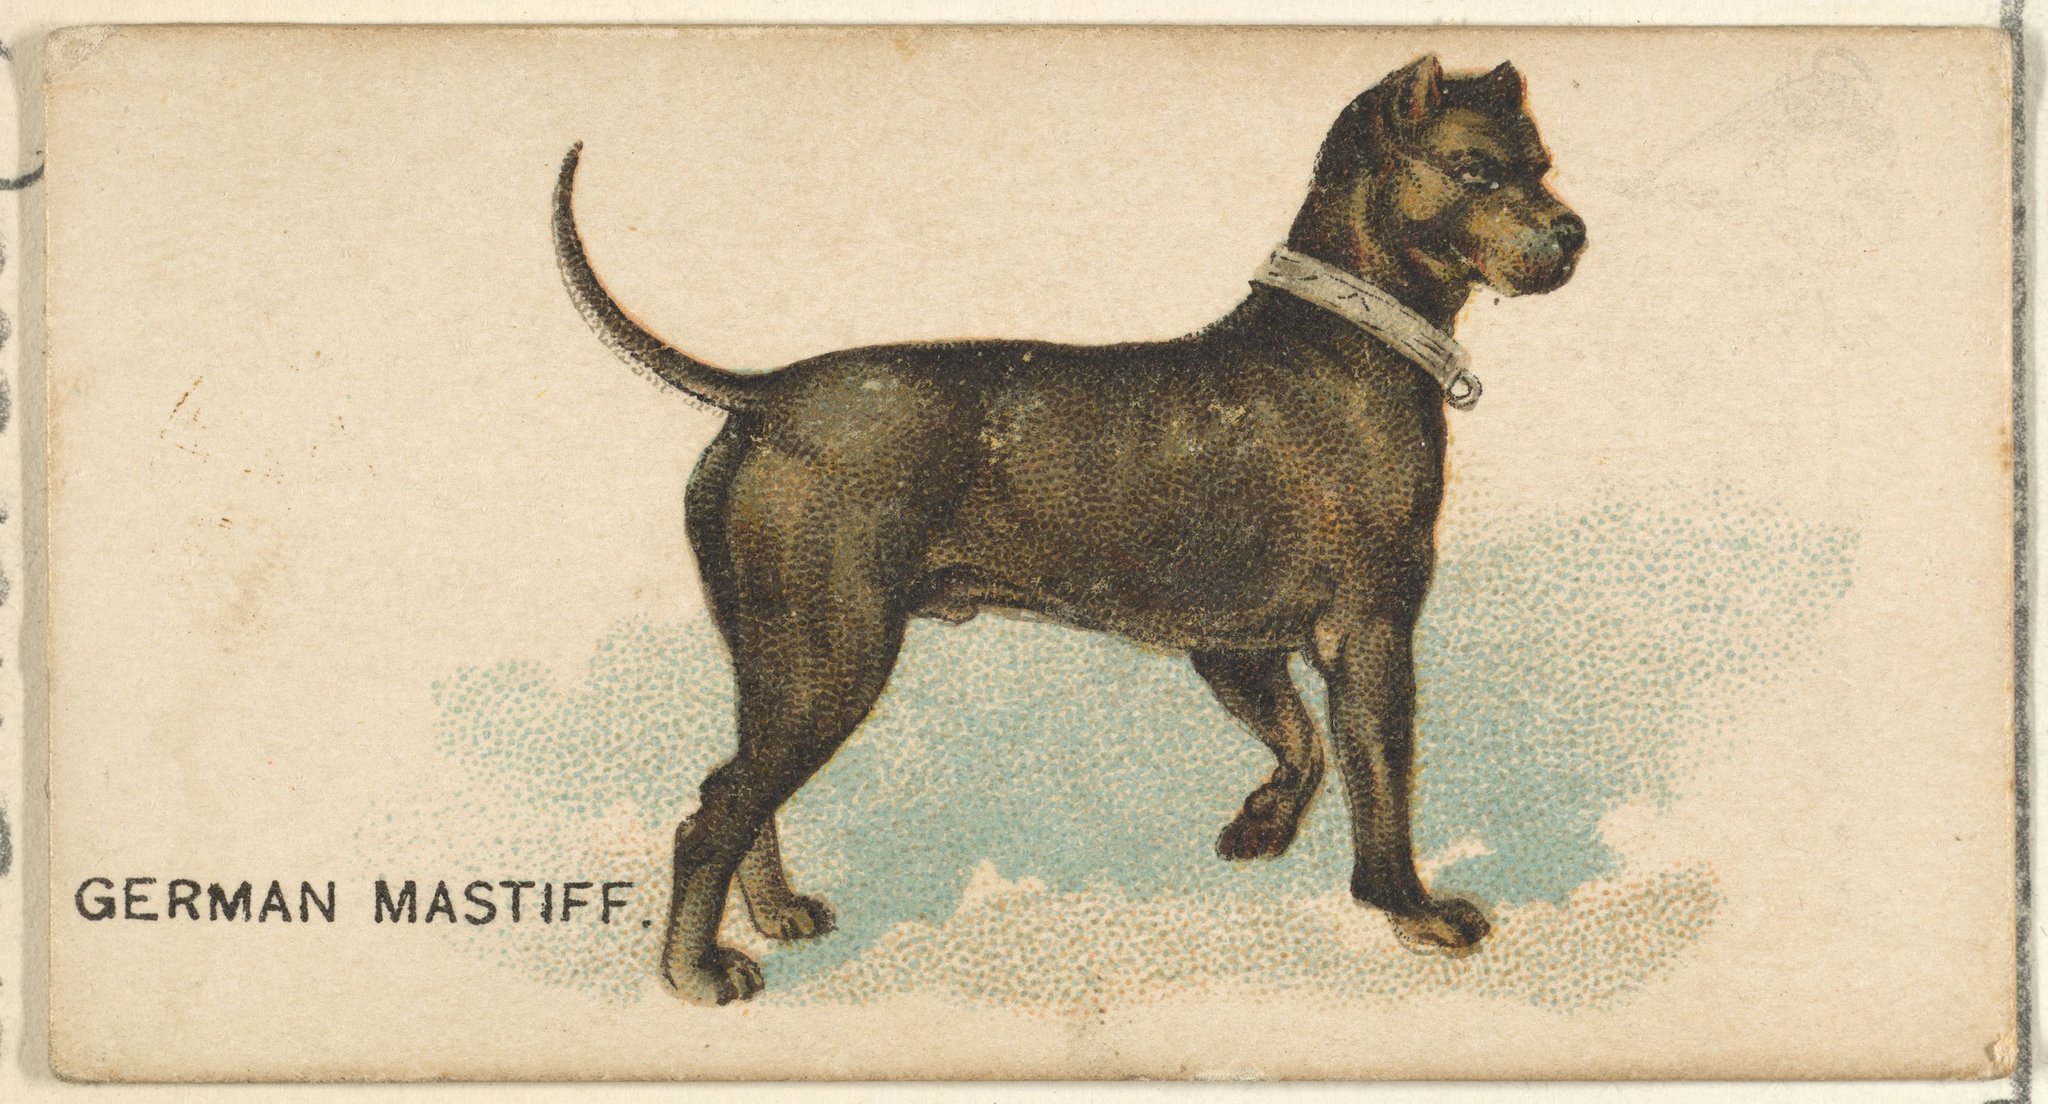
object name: print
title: German Mastiff, from the Dogs of the World series for Old Judge Cigarettes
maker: goodwin & company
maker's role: publisher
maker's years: 1850-1950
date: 1890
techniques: color lithograph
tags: dogs